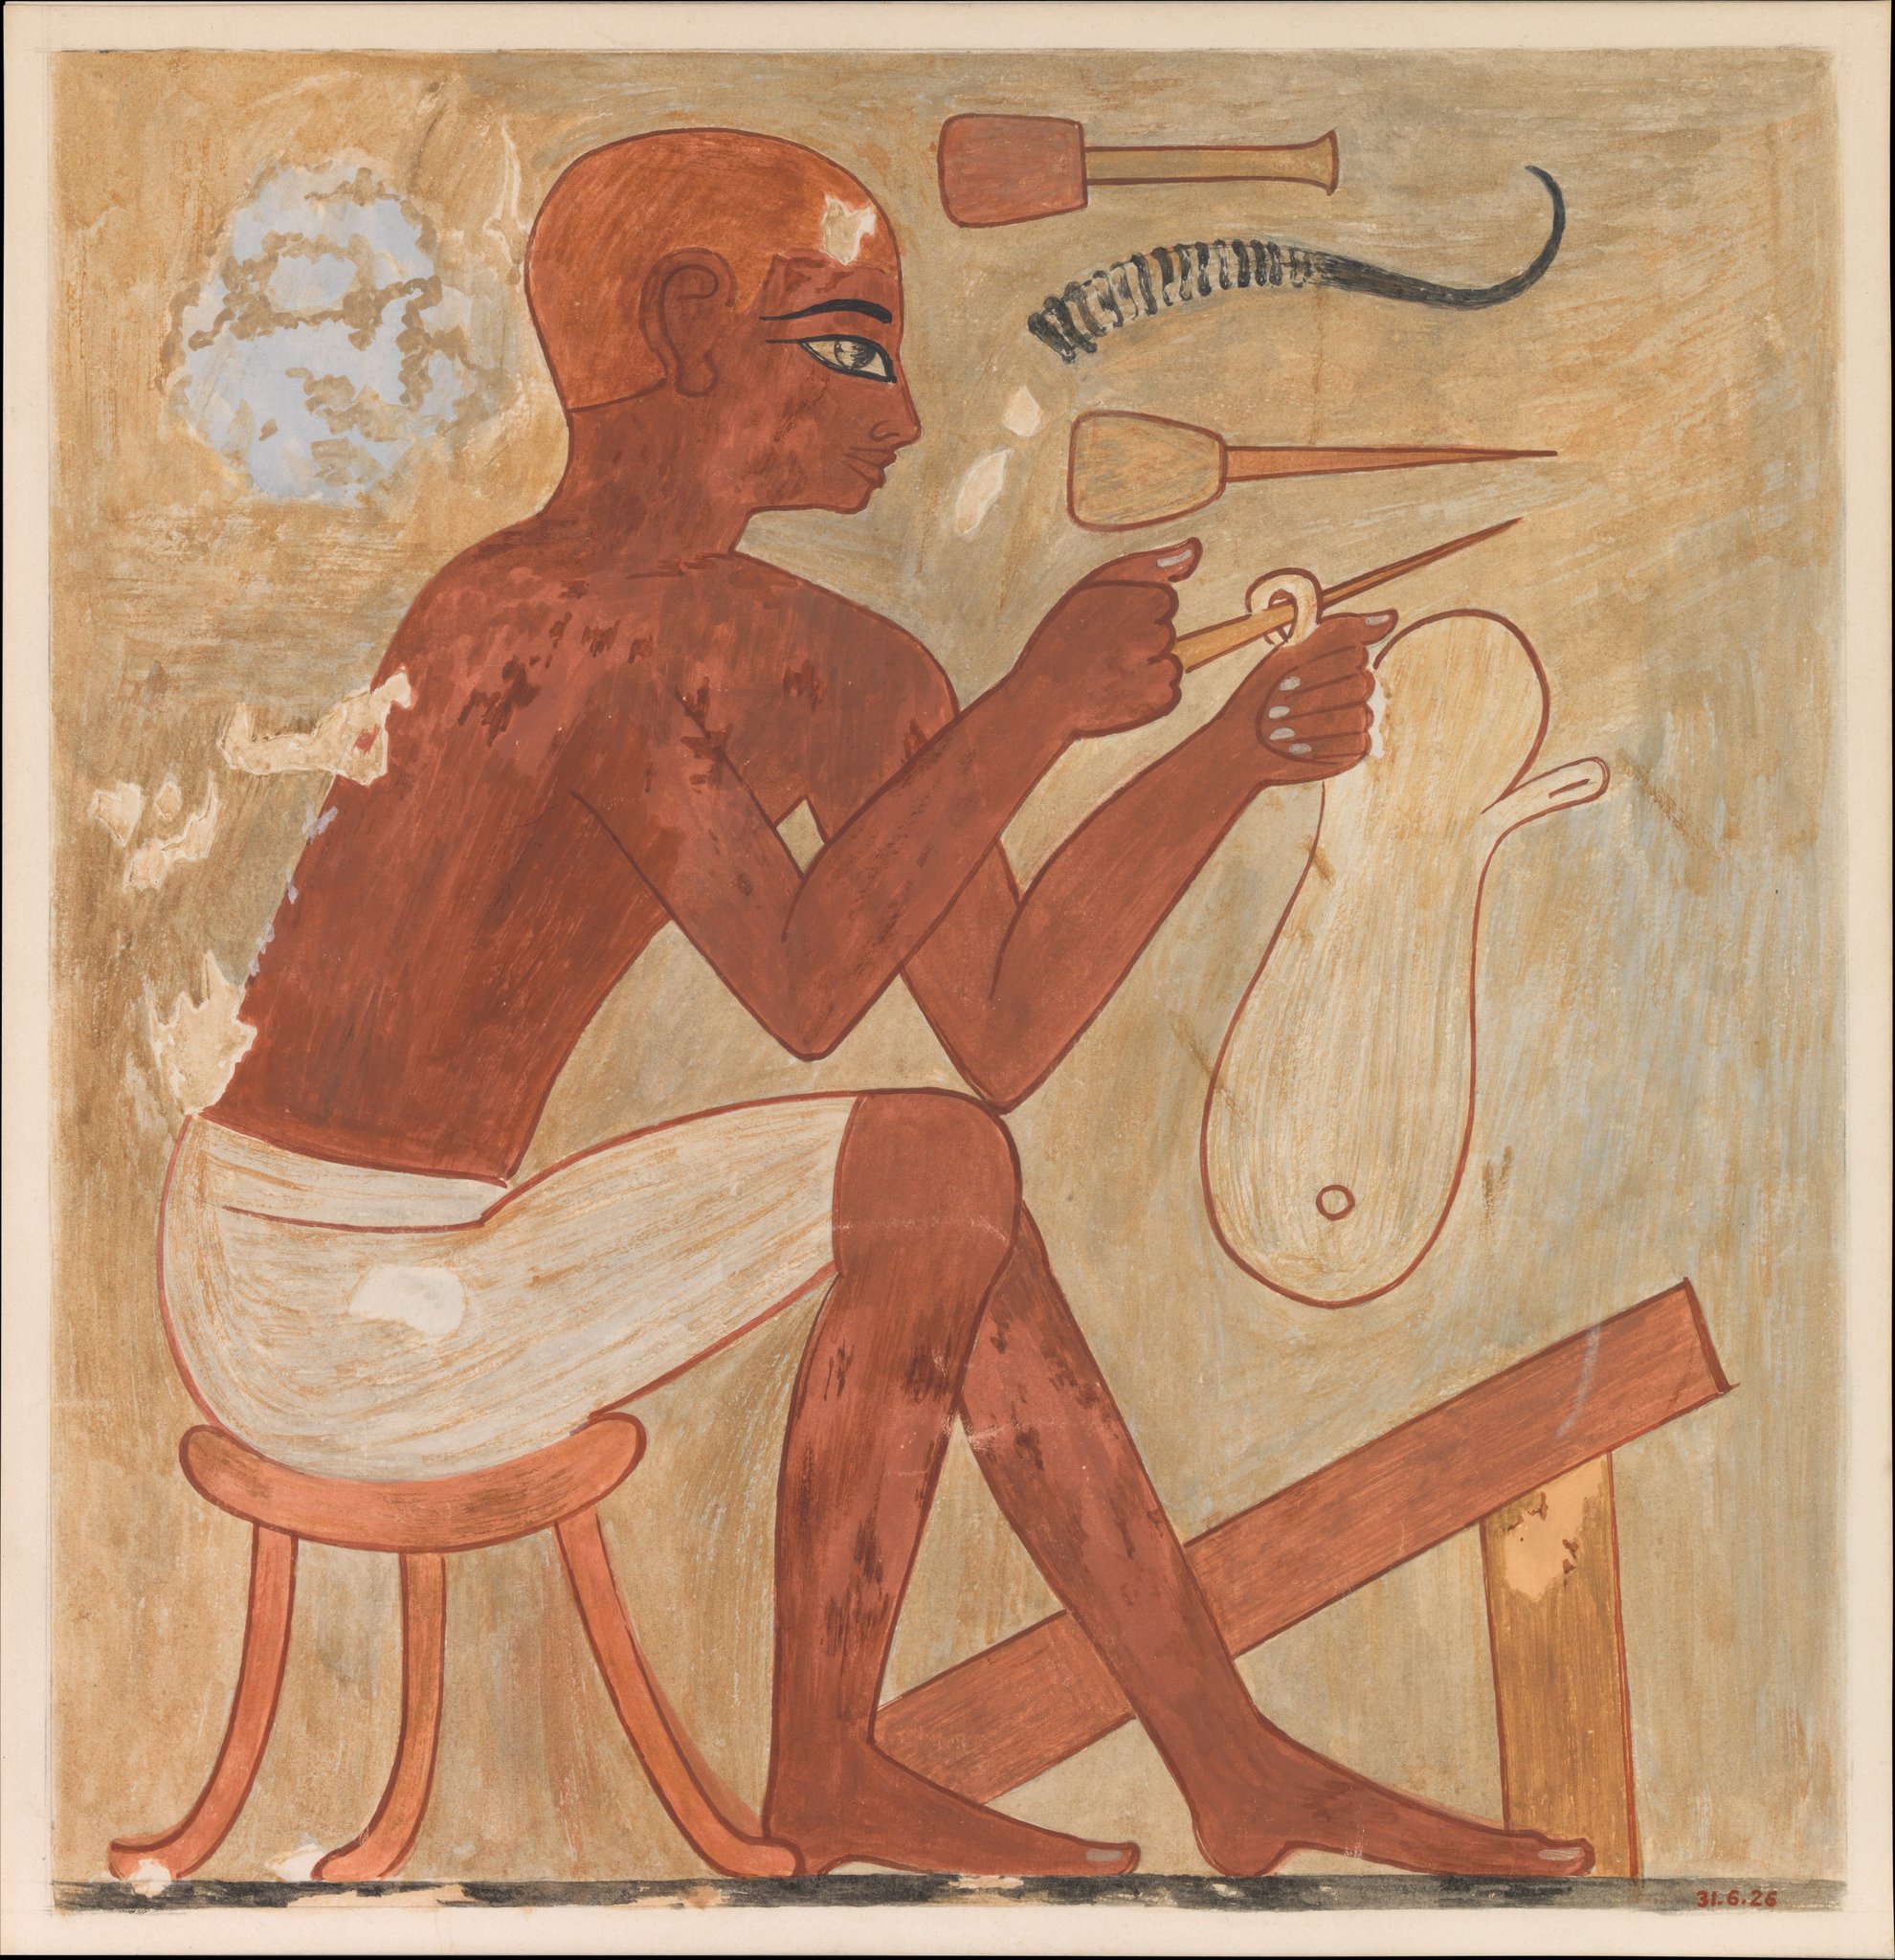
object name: facsimile, rekhmire tt 100, leather work, sandal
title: Sandal Maker, Tomb of Rekhmire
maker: nina de garis davies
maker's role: artist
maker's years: 1881-1965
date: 1504-1425 BCE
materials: ink, paint, paper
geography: egypt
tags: men,working,tools